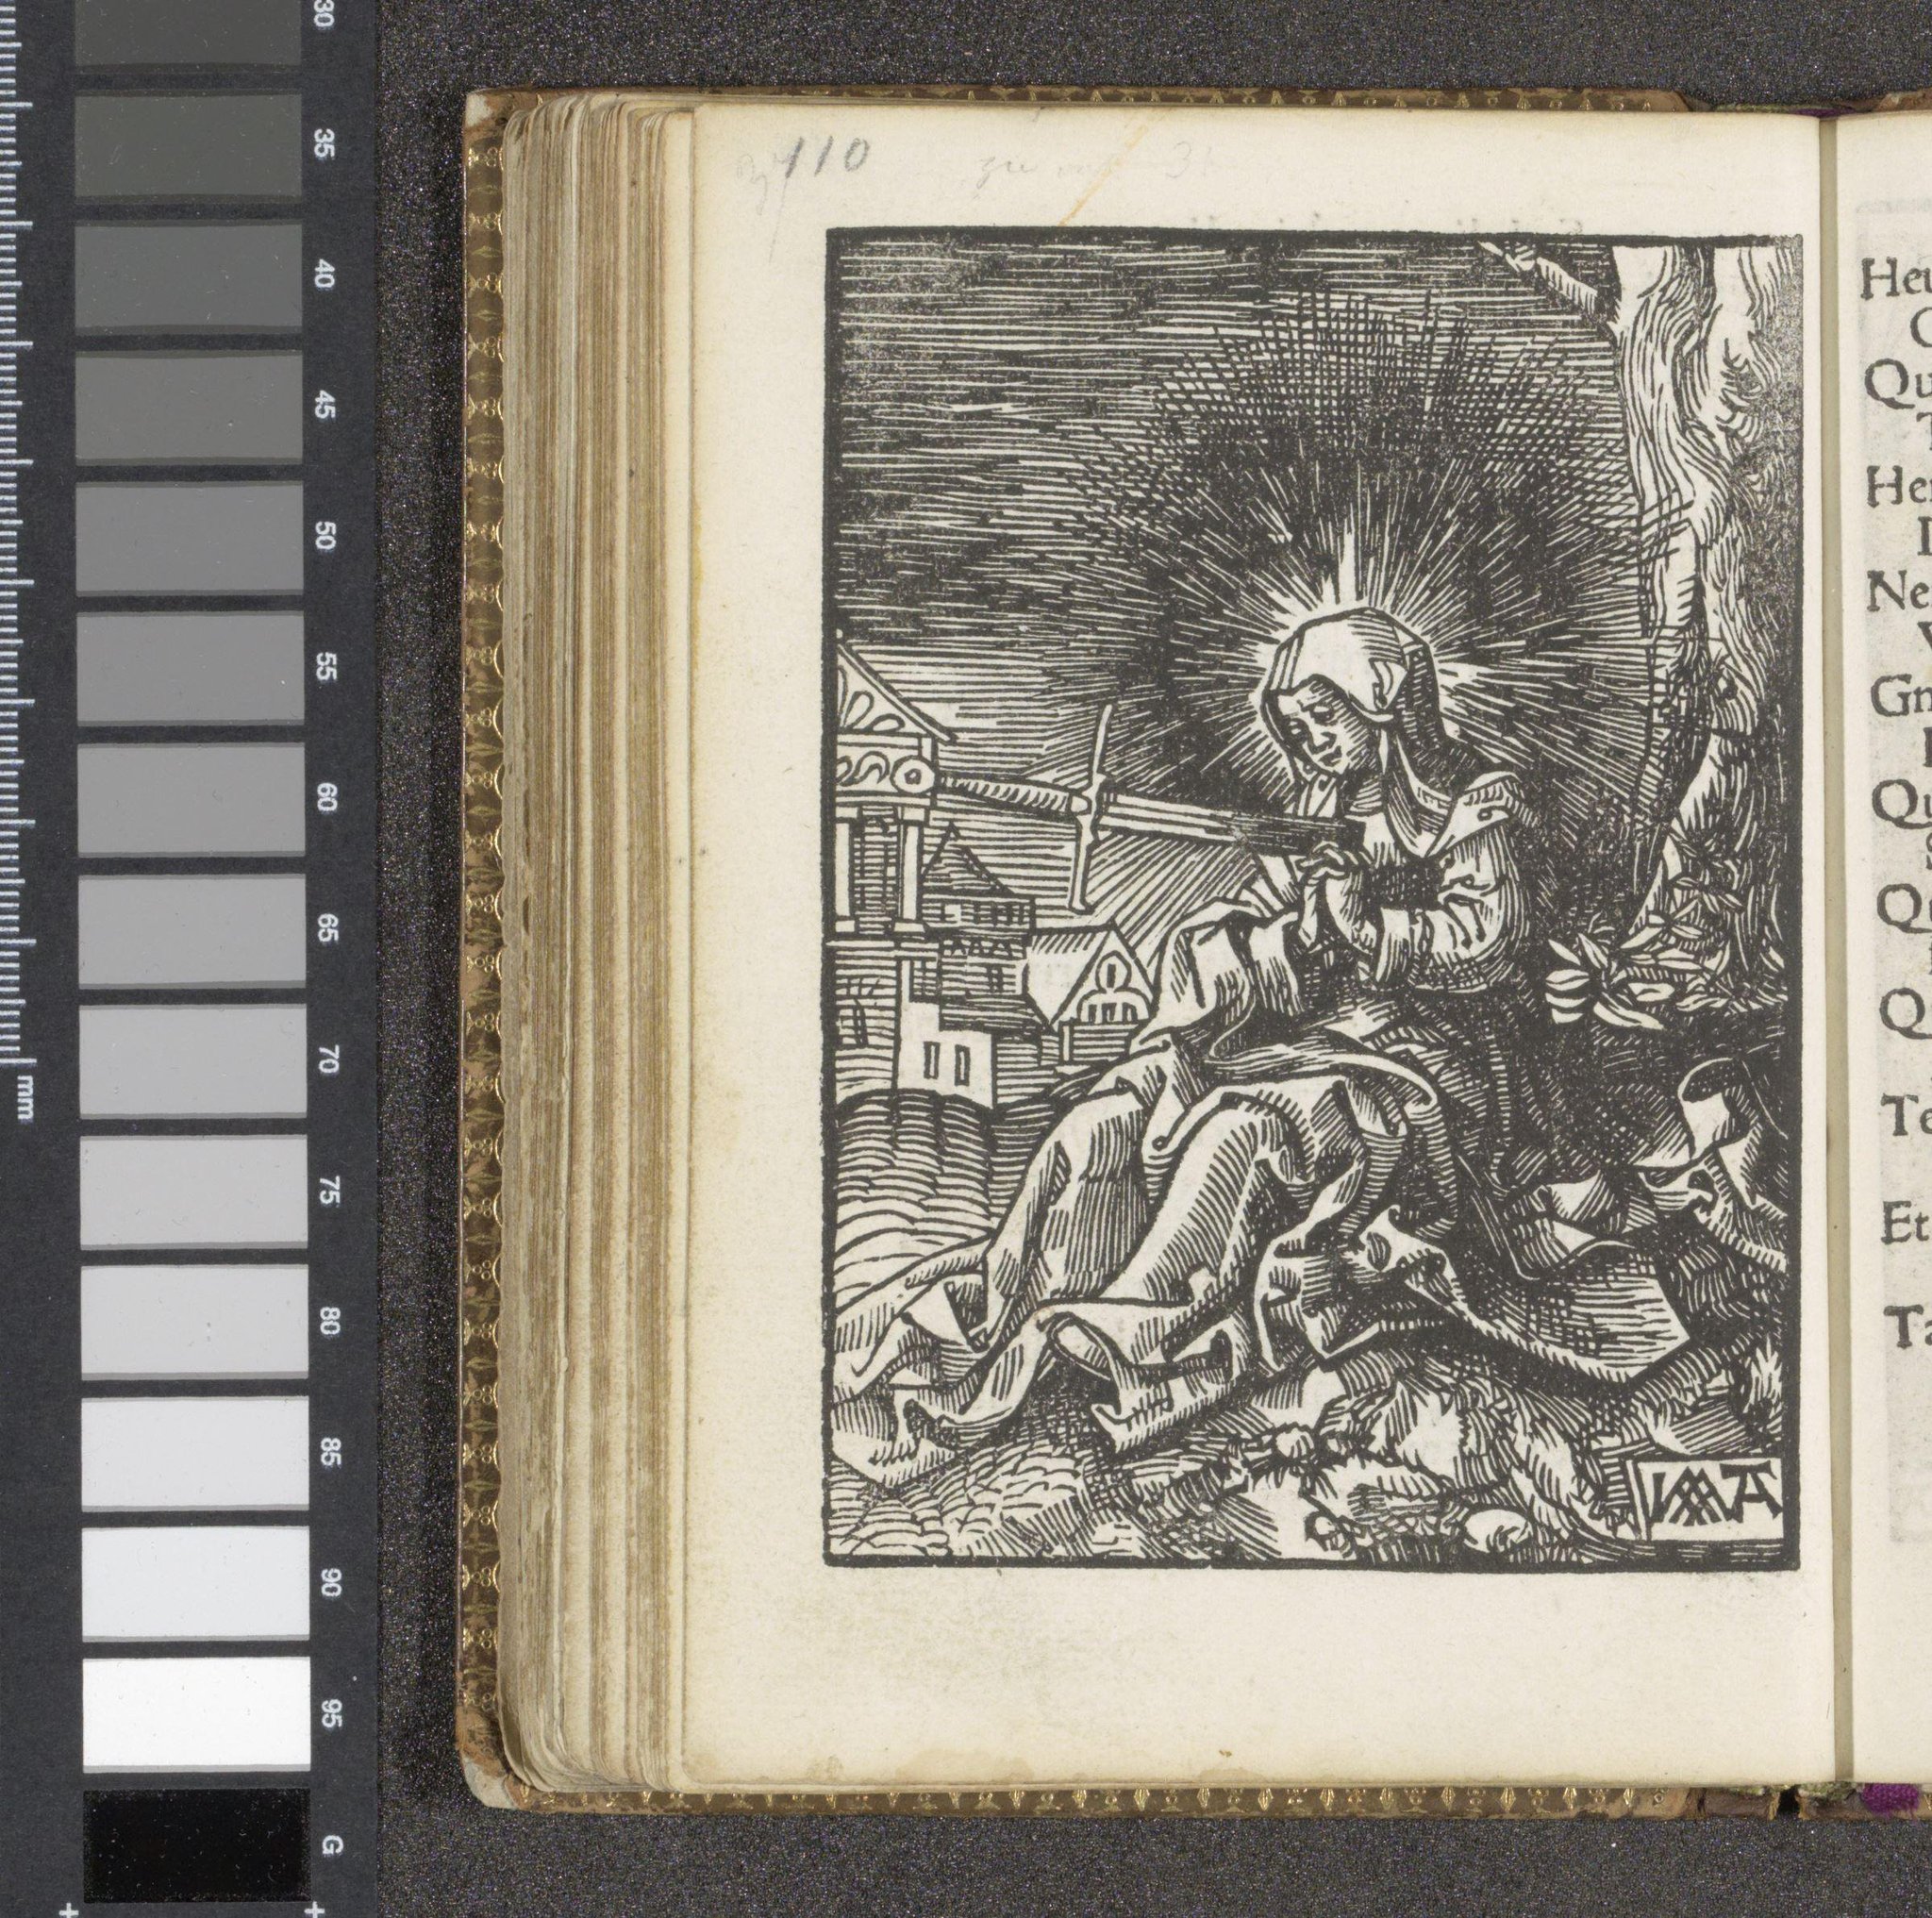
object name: book illustration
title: De kleine Passie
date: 1523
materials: paper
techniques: woodcut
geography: amsterdam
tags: mary pierced by a sword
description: Maria zit op de grond met gevouwen handen. Haar hart doorboord met een zwaard. Prent maakt deel uit van een boek.